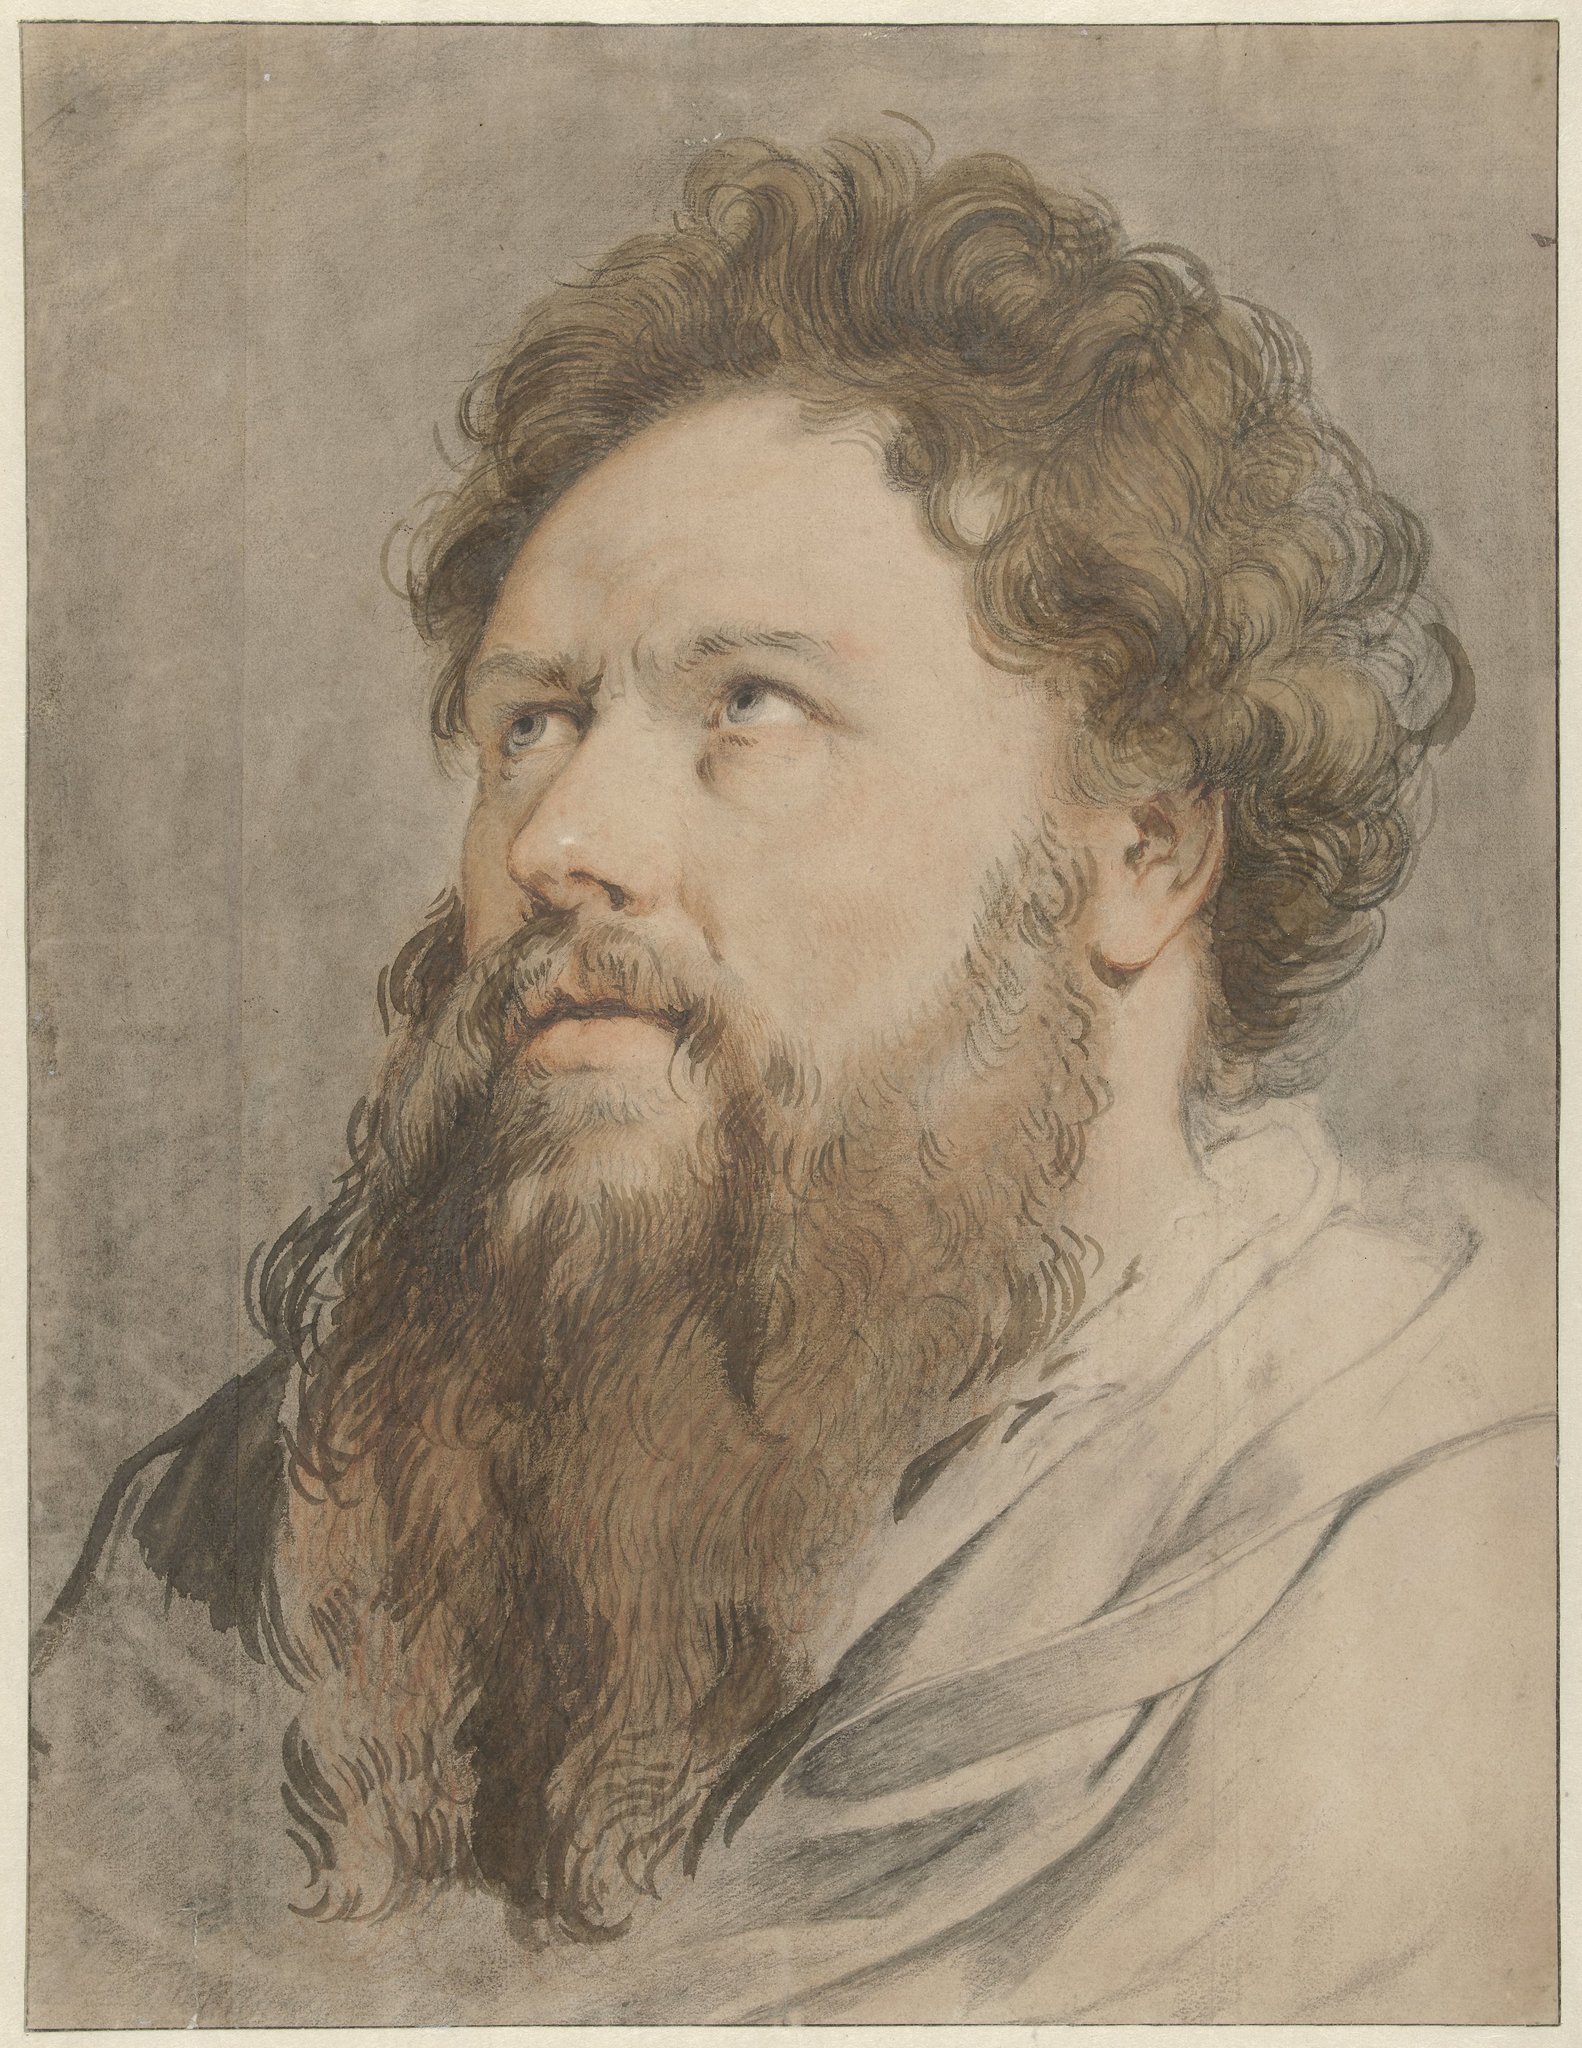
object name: drawing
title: Hoofd van man met baard, de ogen zien opzij naar boven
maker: jacob de wit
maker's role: draughtsman, painter, print maker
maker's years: 1695-1754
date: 1705-1754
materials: chalk, paper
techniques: brush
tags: face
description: Deze tekening is vervaardigd naar een tekening door Hendrick Goltzius in Museum Boijmans Van Beuningen in Rotterdam, Portret van een man met baard (inv.nr. HG 12 (PK)).